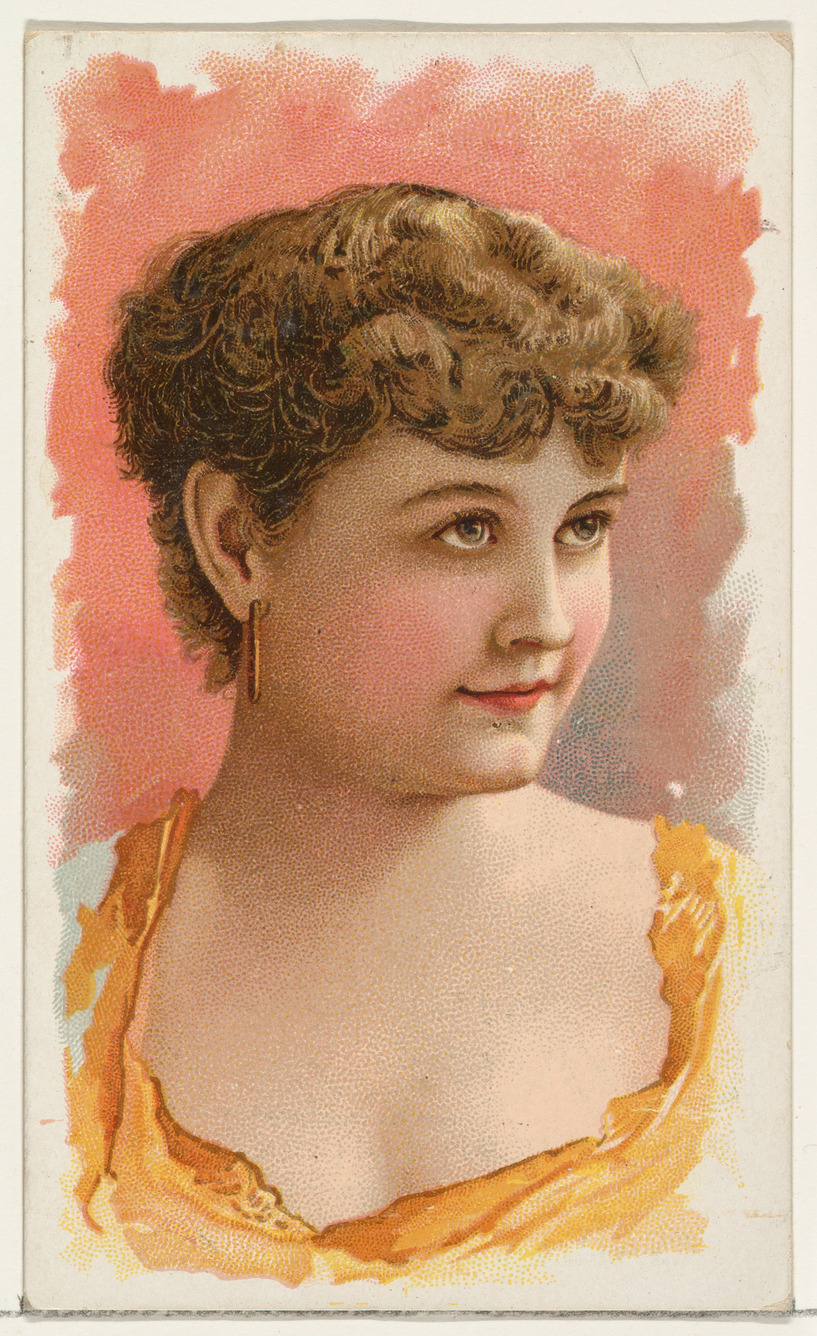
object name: print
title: Actress wearing yellow bodice, from Stars of the Stage, First Series (N129) issued by W. Duke, Sons & Co. to promote Honest Long Cut Tobacco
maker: w. duke, sons & co.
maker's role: publisher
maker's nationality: american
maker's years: 1870-1920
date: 1890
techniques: color lithograph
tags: portraits,women,actresses